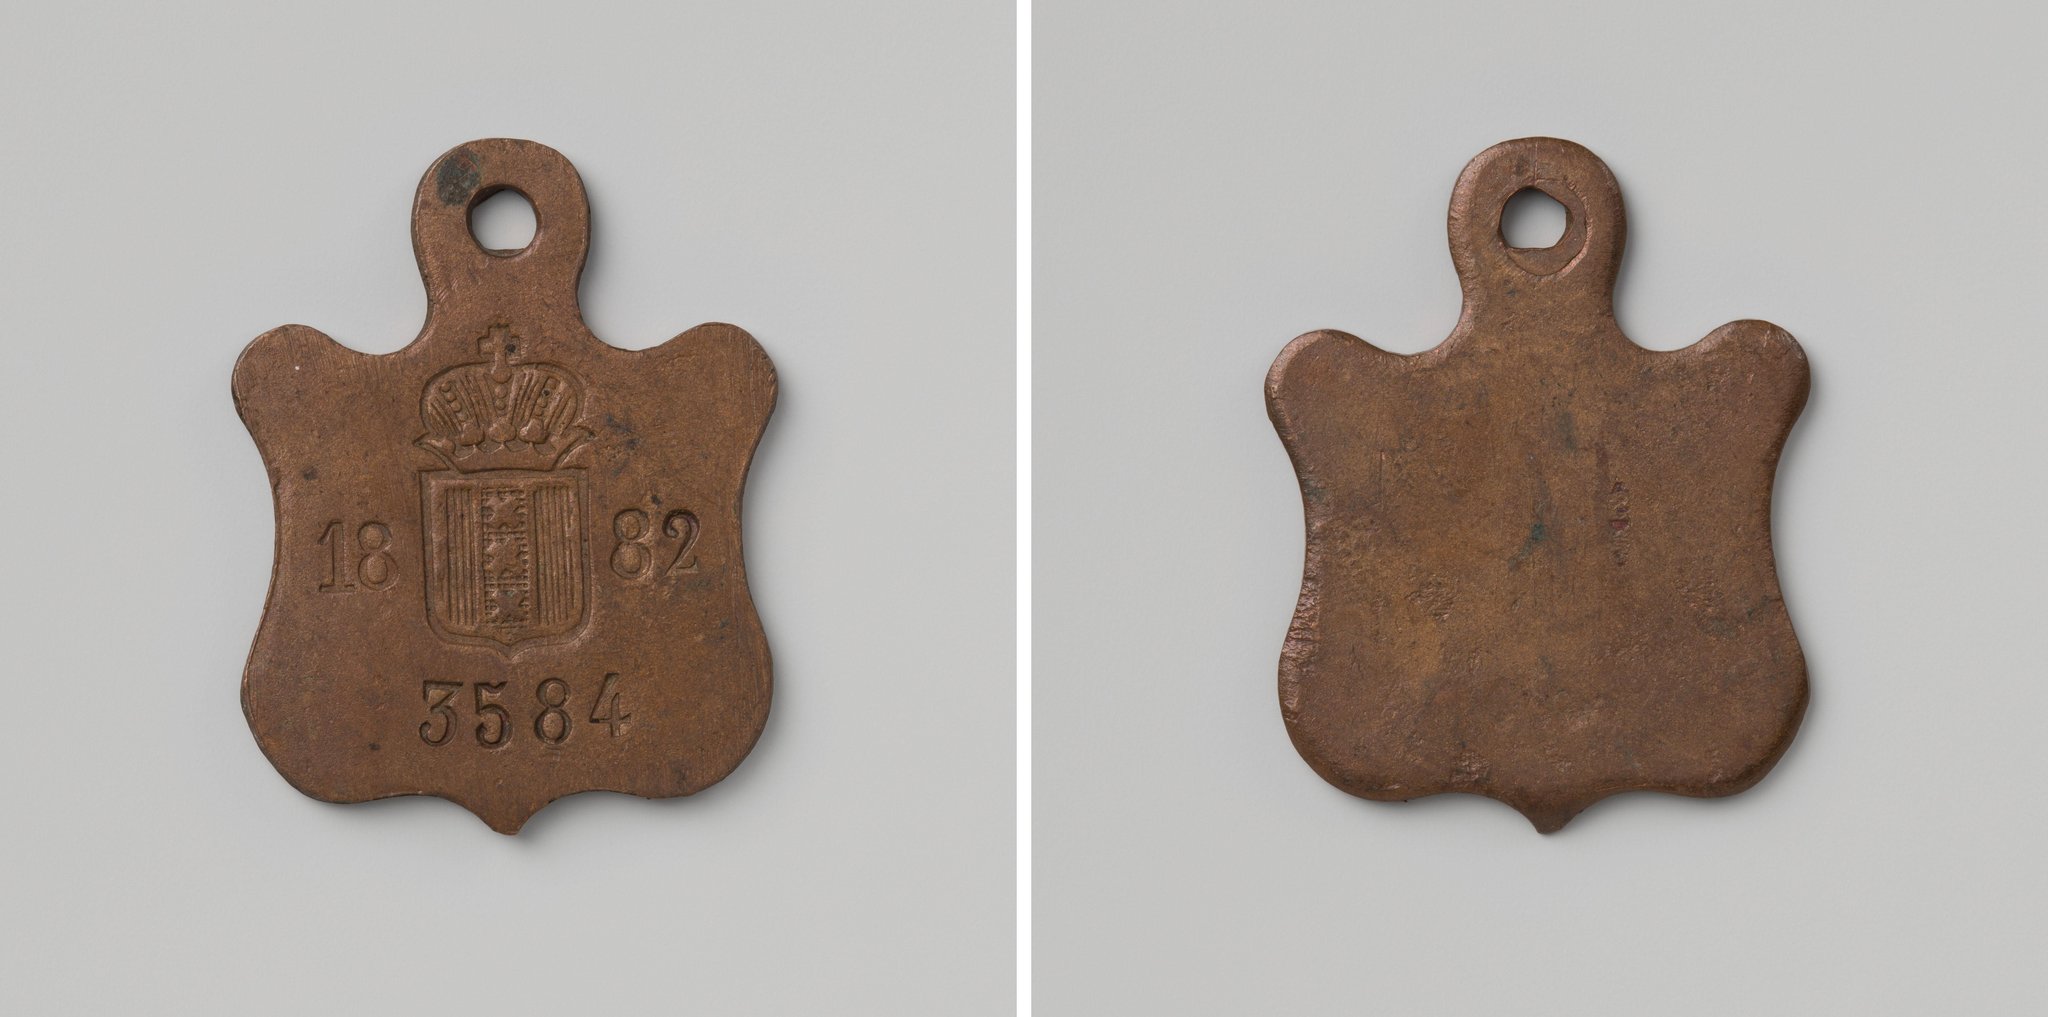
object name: hondenbelastingloodje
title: Stad Amsterdam, loodje met no. 3166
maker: Anonymous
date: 1881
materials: brass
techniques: striking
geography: amsterdam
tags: amsterdam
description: eenzijdig loodje aan draagoog met afgeronde hoeken, holle zijden en aan onderzijde punt. Voorzijde: gekroond wapenschild tussen jaartal boven cijfer 3166. Keerzijde: blanco